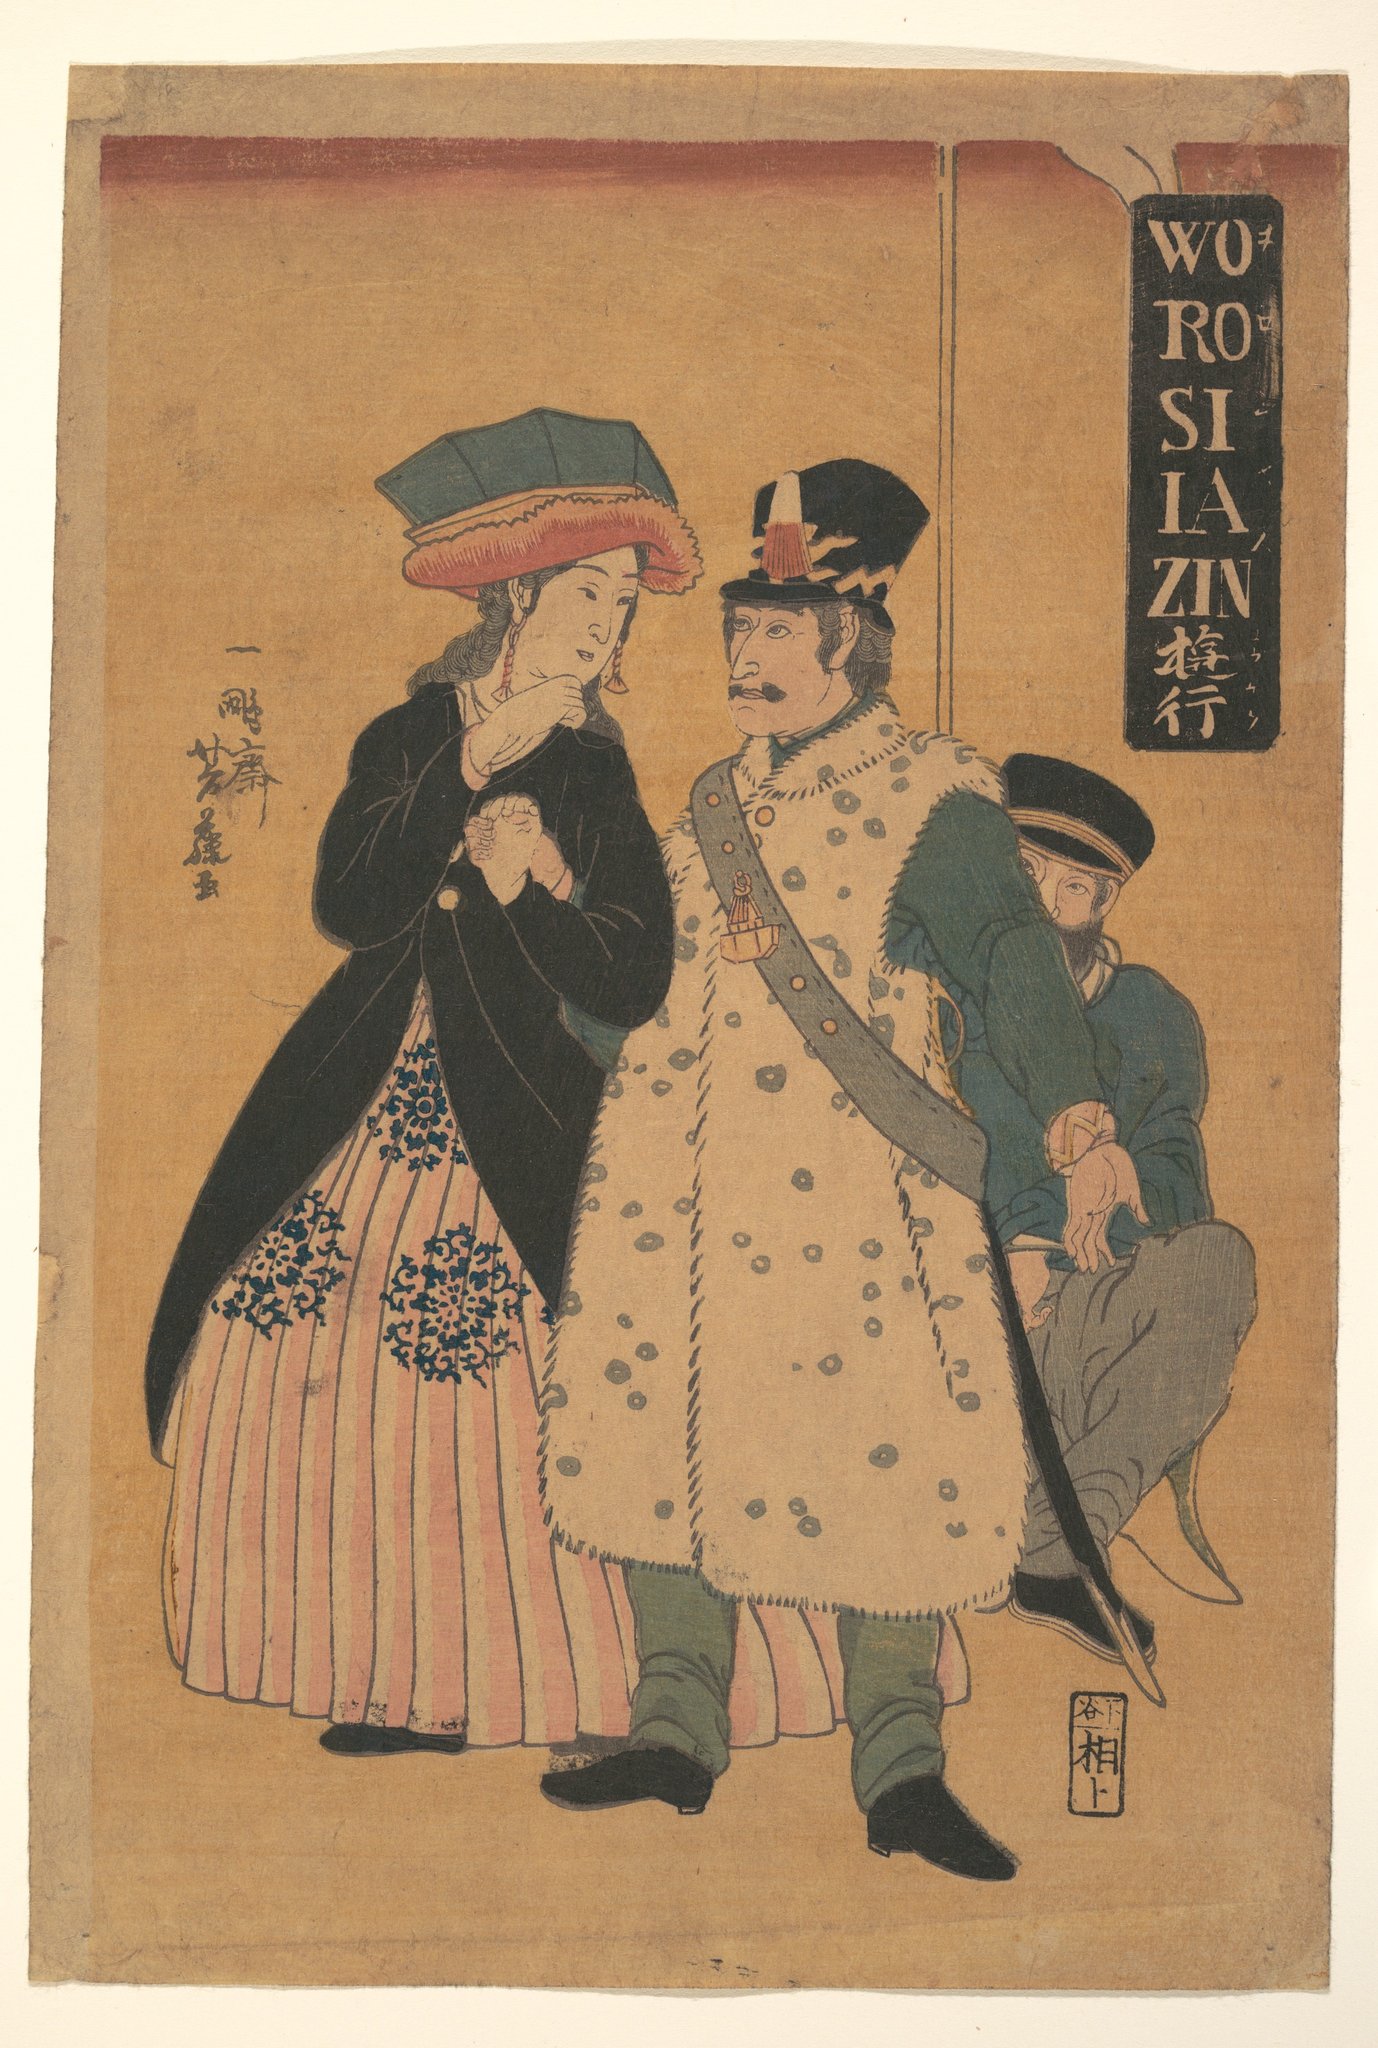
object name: print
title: Russians Strolling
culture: japanese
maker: utagawa yoshifuji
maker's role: artist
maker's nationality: japanese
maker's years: 1828-1887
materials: ink, paper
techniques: woodblock print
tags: men,women